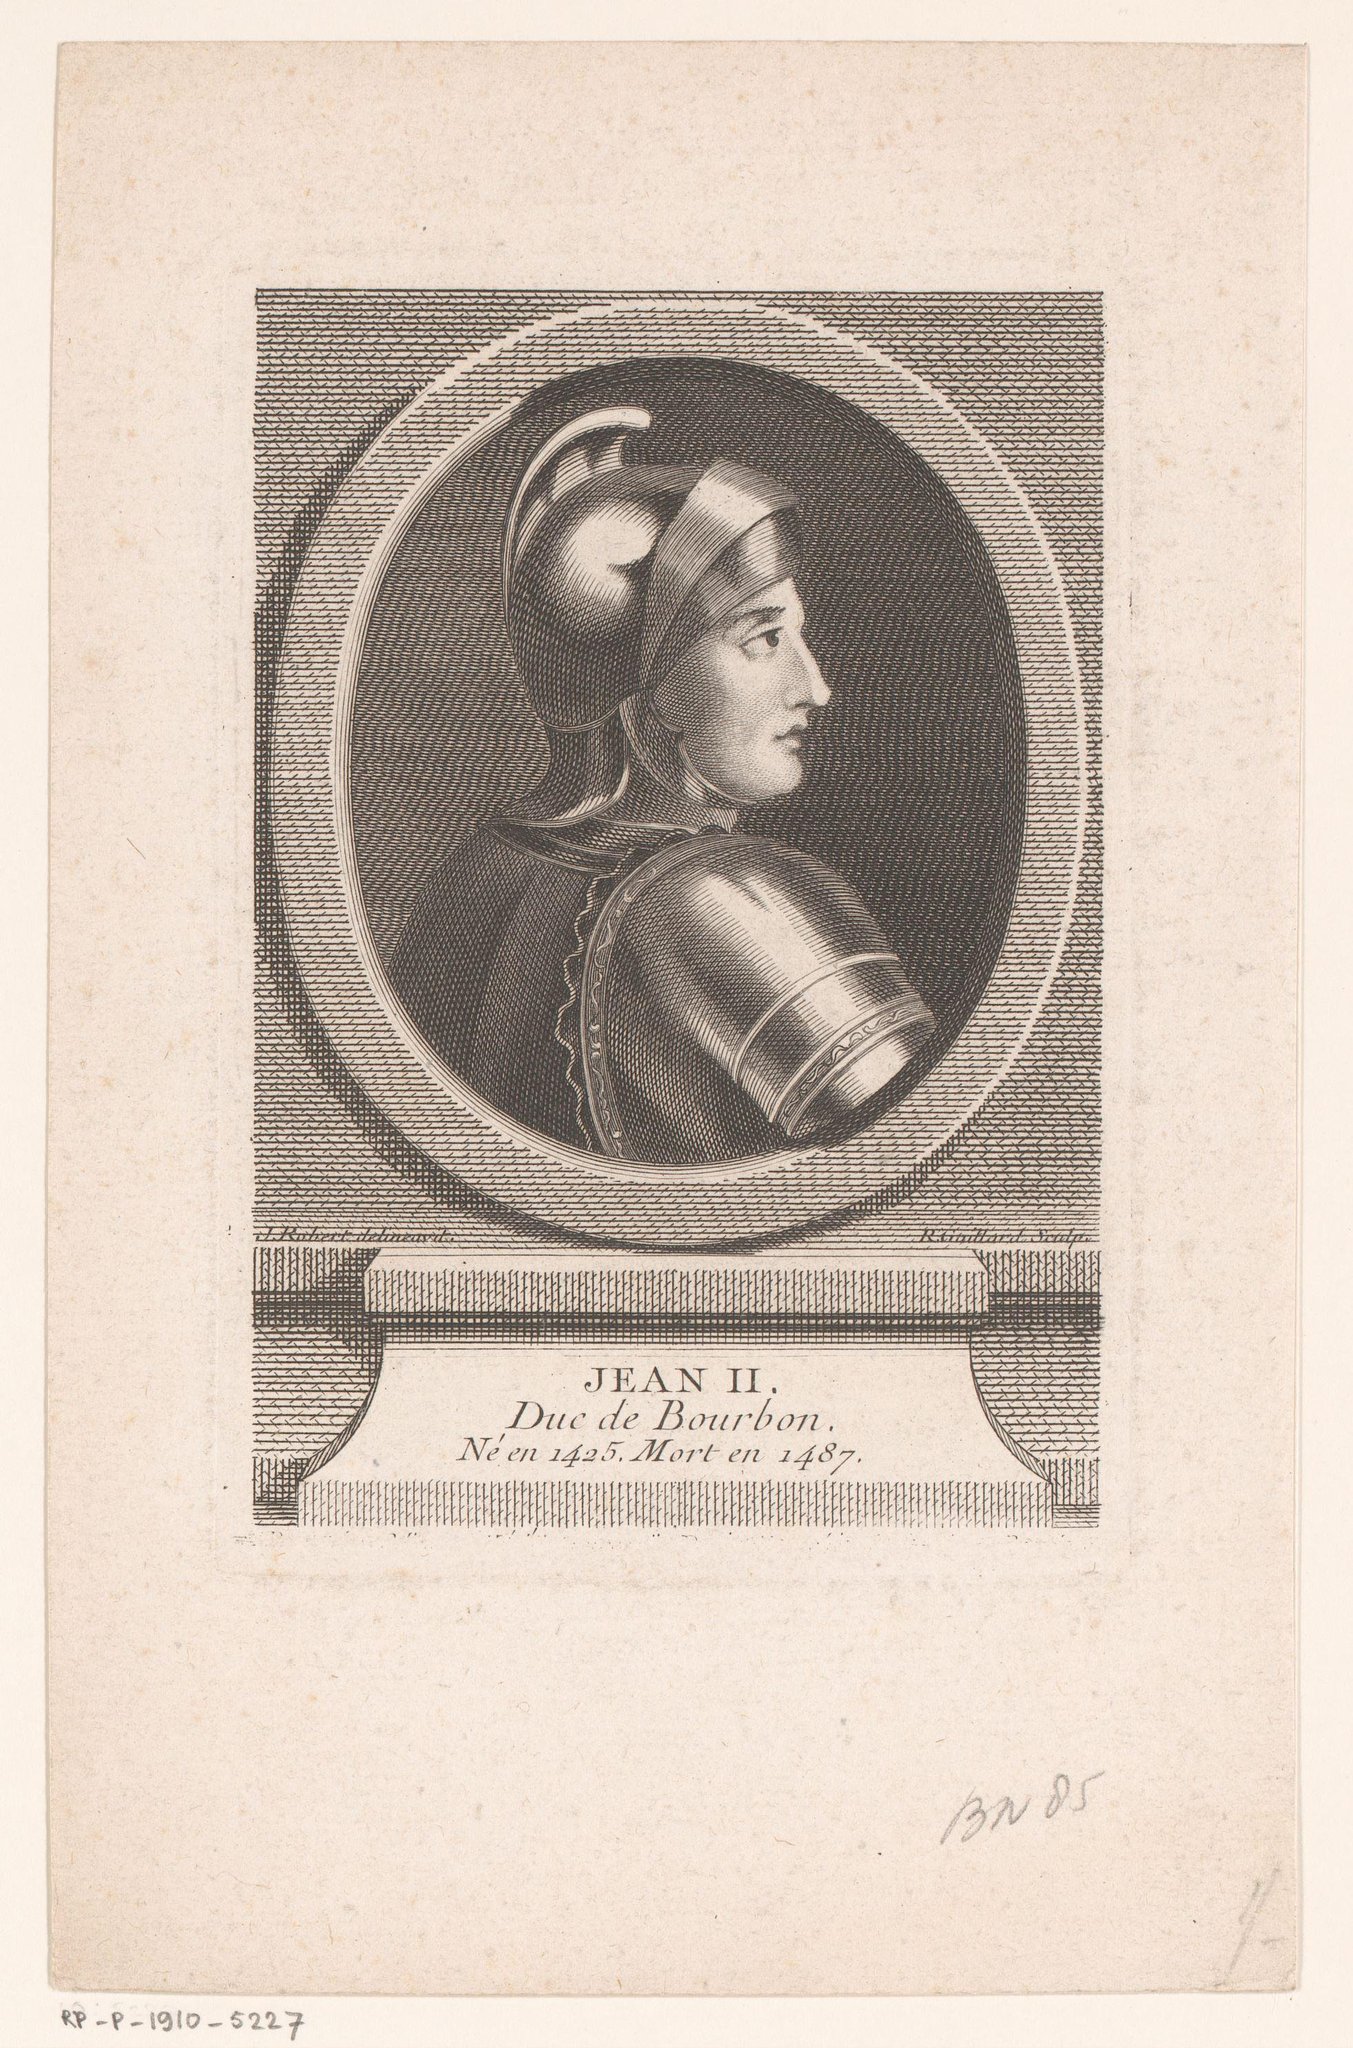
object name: print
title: Portret van Jan II van Bourbon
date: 1755-1765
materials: paper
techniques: engraving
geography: paris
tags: historical persons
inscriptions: collector's mark: Lugt 2228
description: Mogelijk prent uit: Dreux du Radier, Jean-François. L'Europe illustré, contenant l'histoire abregée des souverains, des princes, des prélats, des ministres, (...) en Europe: dans le XVe. siècle compris, jusqu'à présent. Parijs: Michel Odieuvre en André-François Le Breton, 1755-1765, dl. 3.